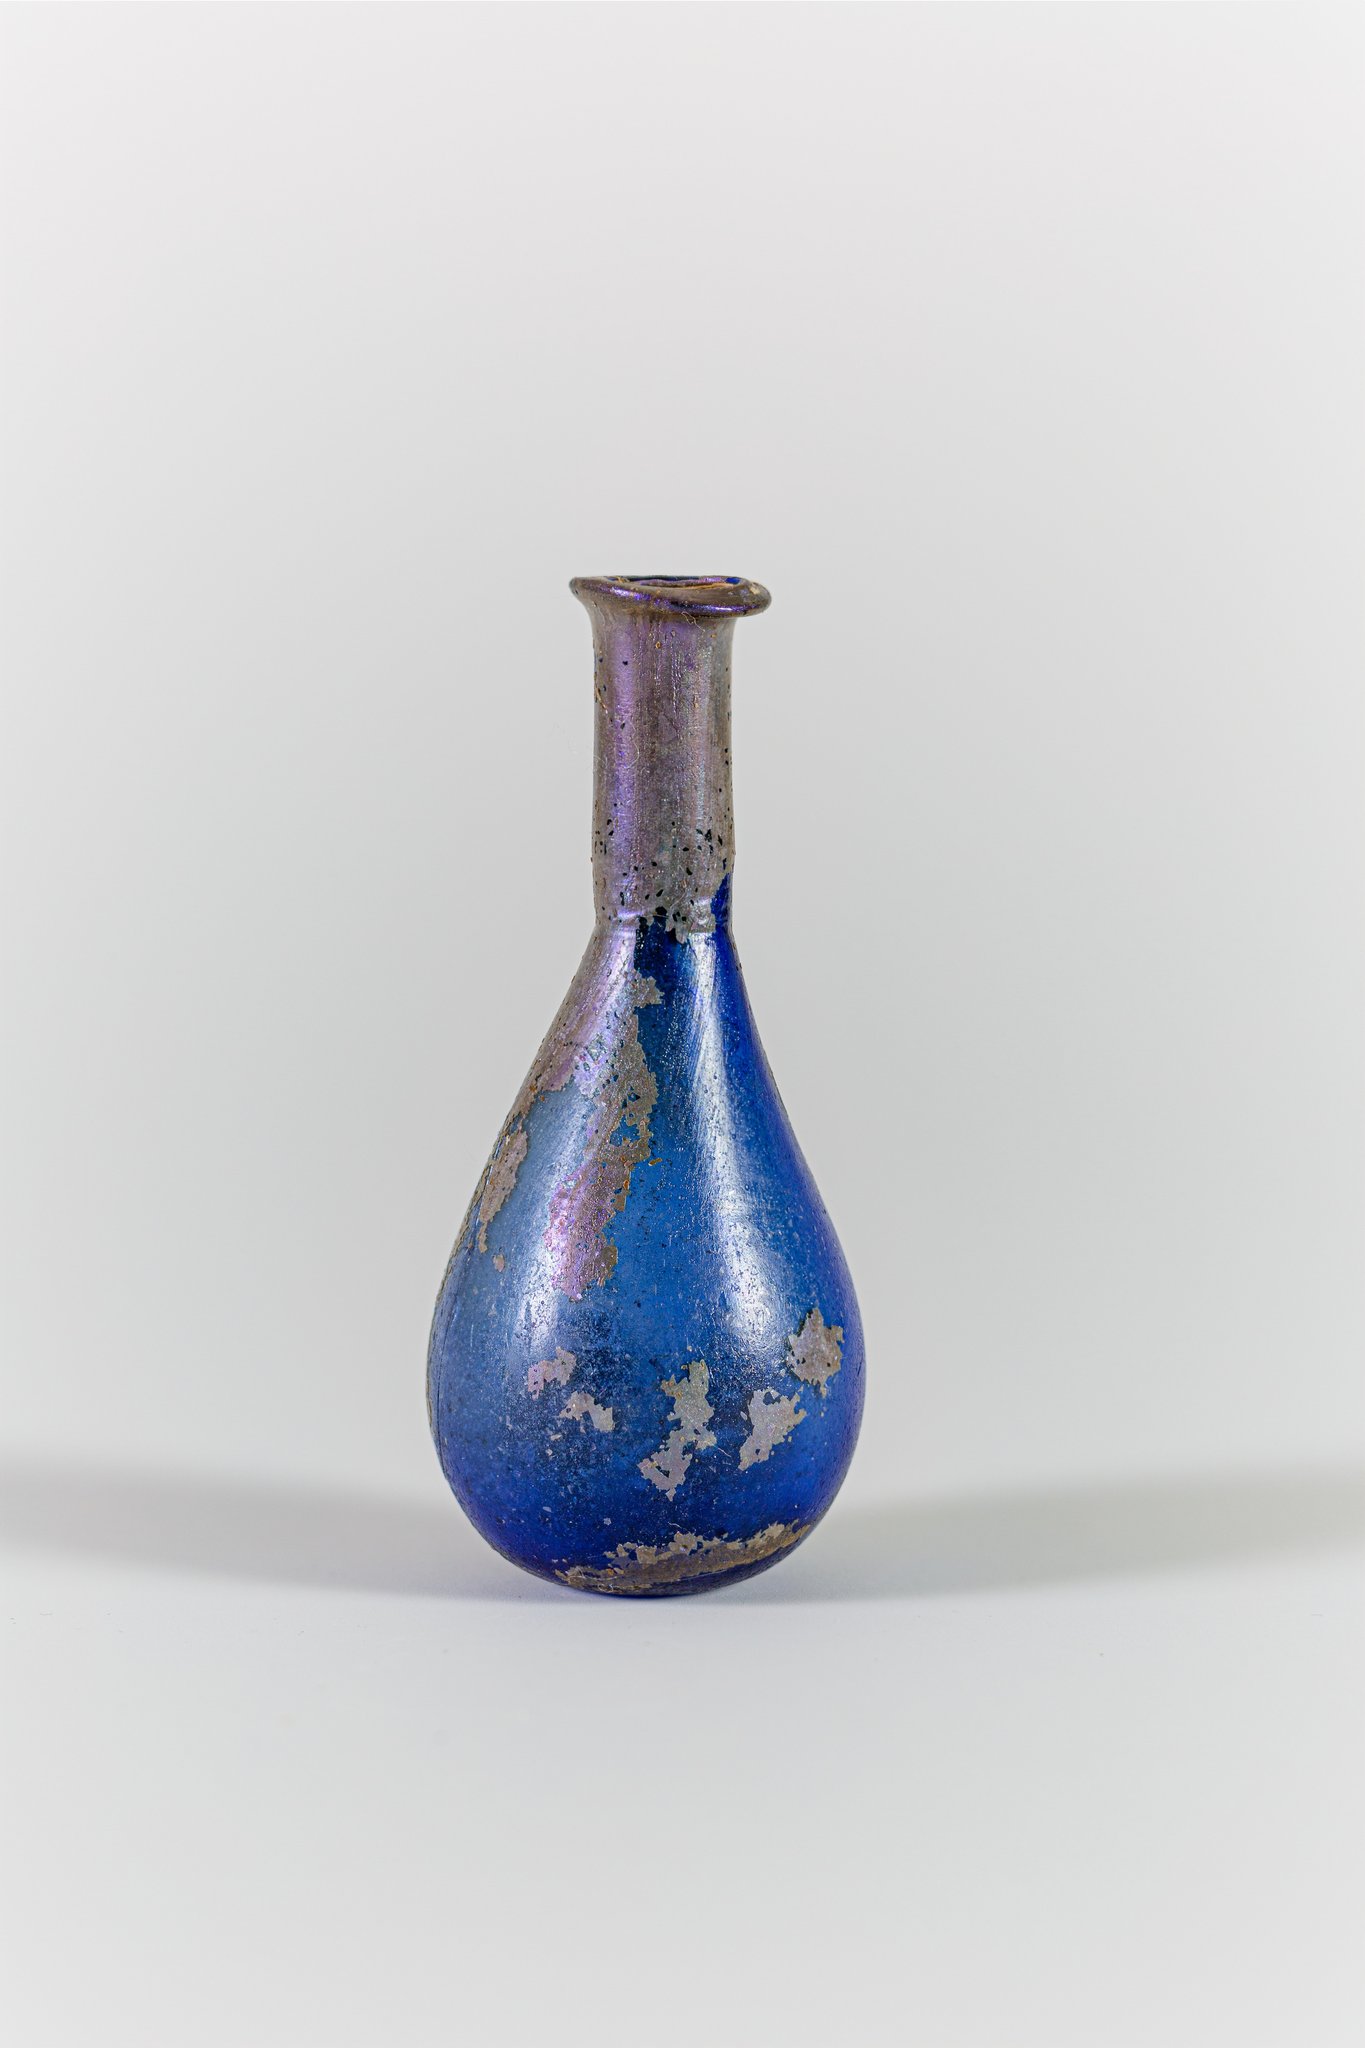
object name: bottle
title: Glass perfume bottle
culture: roman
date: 1-100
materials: glass